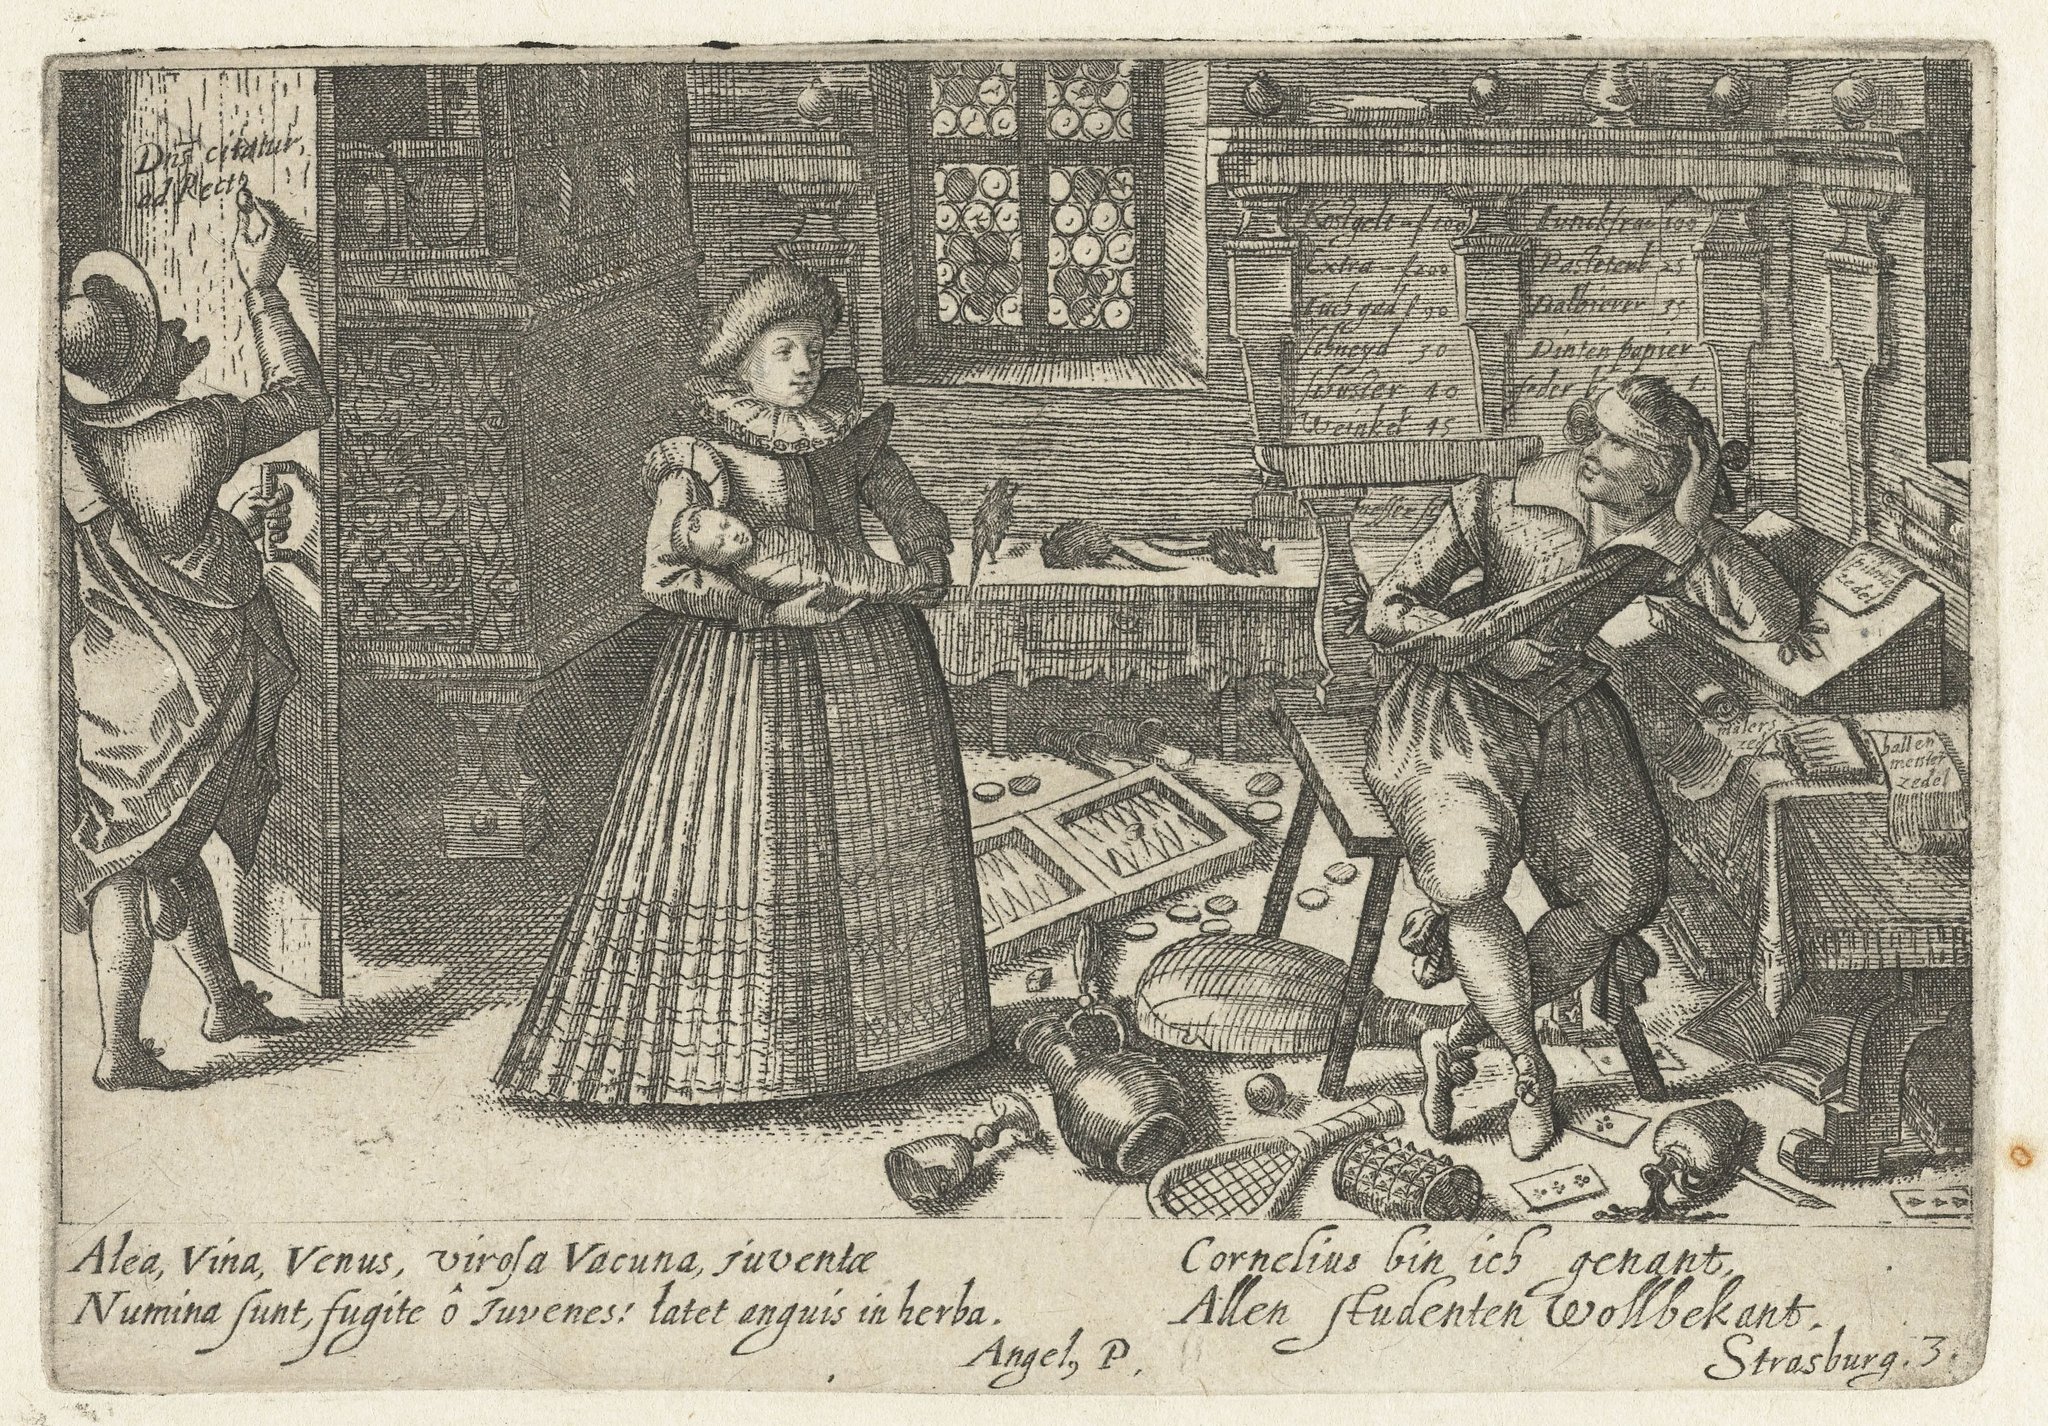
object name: print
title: Vrouw met baby op de arm naast een berooide student met arm in mitella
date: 1608-1618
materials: paper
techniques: engraving, etching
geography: straatsburg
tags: rodents: rat, 'album amicorum', 'stammbuch', student love, sent-down student, games of calculation and chance, e.g.: card games, gambling, puzzles, etc., mother and baby or young child, alcoholic drinks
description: Deze serie, getiteld ‘Pugillus facetiarum iconographicarum in studiosorum (…)’, bestond vermoedelijk uit 36 of meer prenten. Van deze serie zijn in ieder geval twee uitgaven bekend, uit 1608 en 1618. De prenten uit deze serie in de collectie van het Rijksmuseum (RP-P-1996-1 t/m RP-P-1996-36) zijn vermoedelijk afkomstig uit verschillende uitgaven, of uit de tweede uitgave. De inhoud van beide uitgaven verschilt, maar om de precieze inhoud van de verschillende uitgaven vast te stellen is meer onderzoek nodig. Er zijn geen volledige exemplaren van de eerste uitgave bekend. Aan de hand van de analyse van een andere serie, ‘Jeucht spieghel’,* die kopieën van ‘Pugillus’ bevat en is uitgegeven in 1610 én de aanwezige exemplaren van prenten uit ‘Pugillus’ in een inmiddels verloren album amicorum uit 1610,** kan in ieder geval van een aantal prenten gesteld worden dat ze al voorkwamen in de uitgave van 1608. Dit geldt voor RP-P-1996-1 (de titelprent), RP-P-1996-5, RP-P-1996-6, RP-P-1996-7, RP-P-1996-8, RP-P-1996-9, RP-P-1996-10, RP-P-1996-11, RP-P-1996-12, RP-P-1996-13, RP-P-1996-14, RP-P-1996-15, RP-P-1996-16, RP-P-1996-17, RP-P-1996-18, RP-P-1996-19, RP-P-1996-24, RP-P-1996-28, RP-P-1996-29, RP-P-1996-33 en RP-P-1996-35. Van één prent (RP-P-1996-31) kan vastgesteld worden dat die pas in de latere uitgave van 1618 voorkwam, omdat het kopie is van een prent uit weer een andere serie, ‘Academia sive speculum vitae scholasticae (…)’, die werd uitgegeven in 1612.*** Van de huidige prent is onduidelijk of hij al voorkwam in de uitgave van 1608. * Z.G.H.P.H.S [Zacharias Heyns]. Jeucht spieghel. S.l.s.n., 1610. Voor een gedigitaliseerd exemplaar zie: https://archive.org/details/ned-kbn-all-00000628-001/page/n9/mode/2up. ** Zie: Erman, Wilhelm en Ewald Horn. Bibliographie der deutschen Universitäten, systematisch geordnetes Verzeichnis der bis Ende 1899 gedruckten Bücher und Aufsätze über das deutsche Universitätswesen. Leipzig en Berlijn: Verlag von B.G. Teubner, 1904, dl. 1, p. 826-832, no. 17328. https://archive.org/details/bibliographieder01ermauoft/page/826/mode/2up *** Passe, Crispijn van de (I). Academia sive speculum vitae scholasticae (…). Arnhem: Johannes Janssonius [Jan Jansz.], 1612. Voor een gedigitaliseerd exemplaar zie: http://gallica.bnf.fr/ark:/12148/btv1b55005974h.